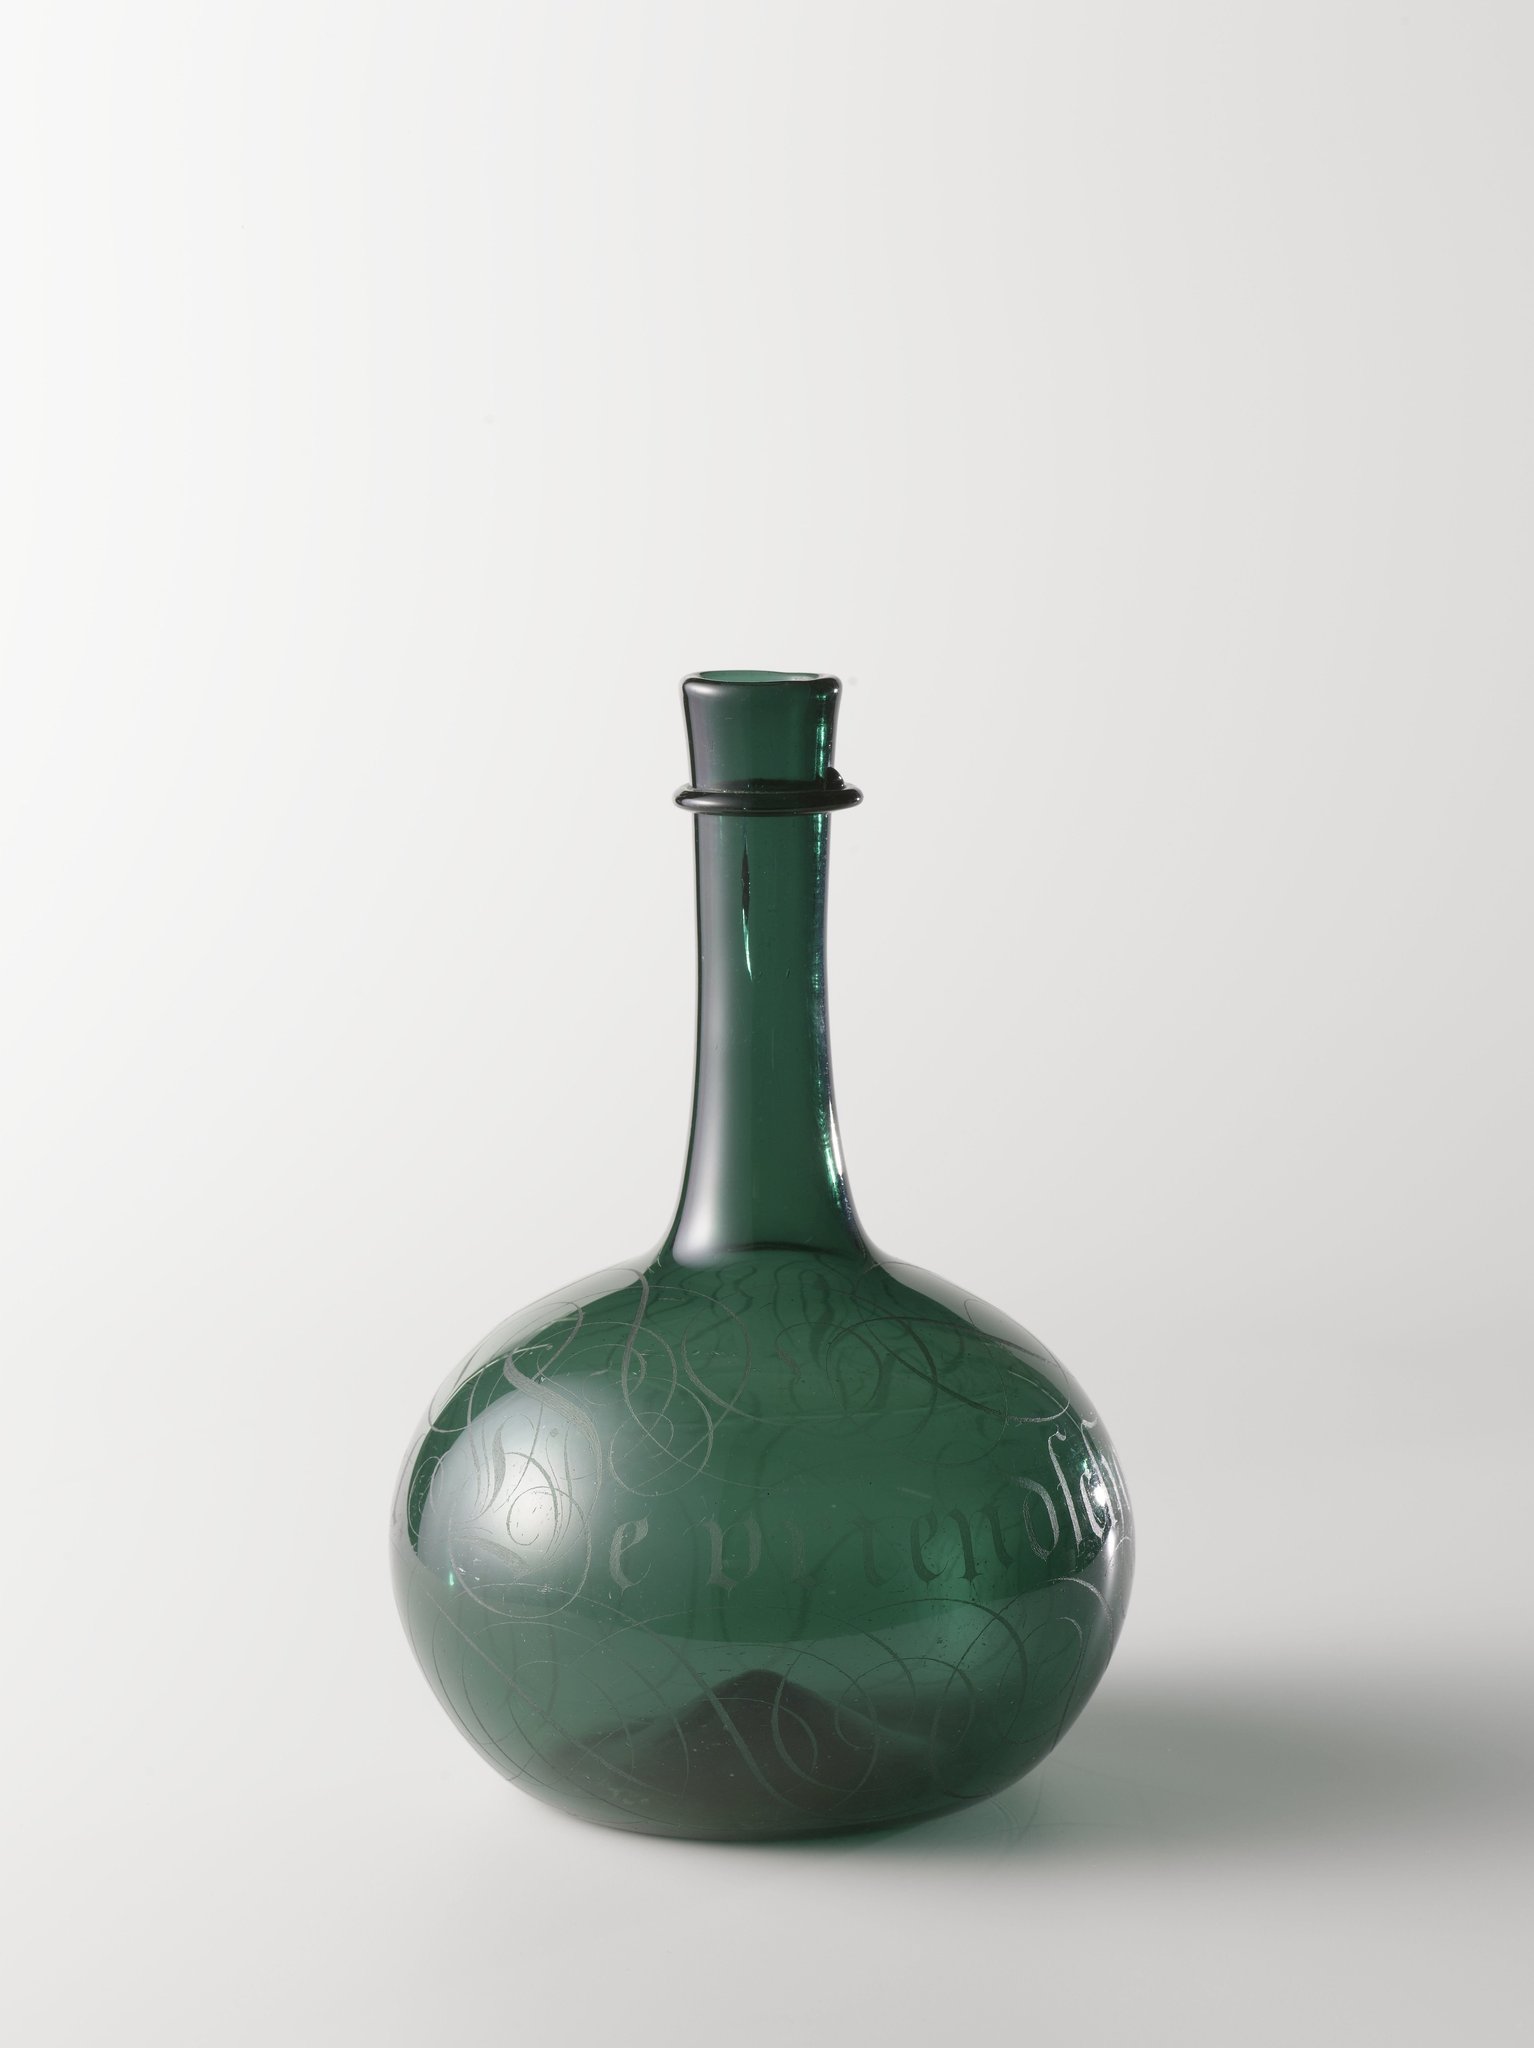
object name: sierfles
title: Fles met het opschrift: De vriendschap is 's Leevens sout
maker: mathieu petit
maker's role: draughtsman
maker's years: -1721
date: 1687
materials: glass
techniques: diamond point engraving, glassblowing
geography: northern netherlands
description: Ingestoken ziel. Bolvormig lichaam, lange slanke hals met opgelegde ring rond de nek. Op lichaam gecalligrafeerd opschrift: 'De vriendschap is 's Leevens sout.'. Onder de gravure de signatuur 'Petit' en op de bodem 'M Petit SchryfMr A Leyden Anno 1687'.